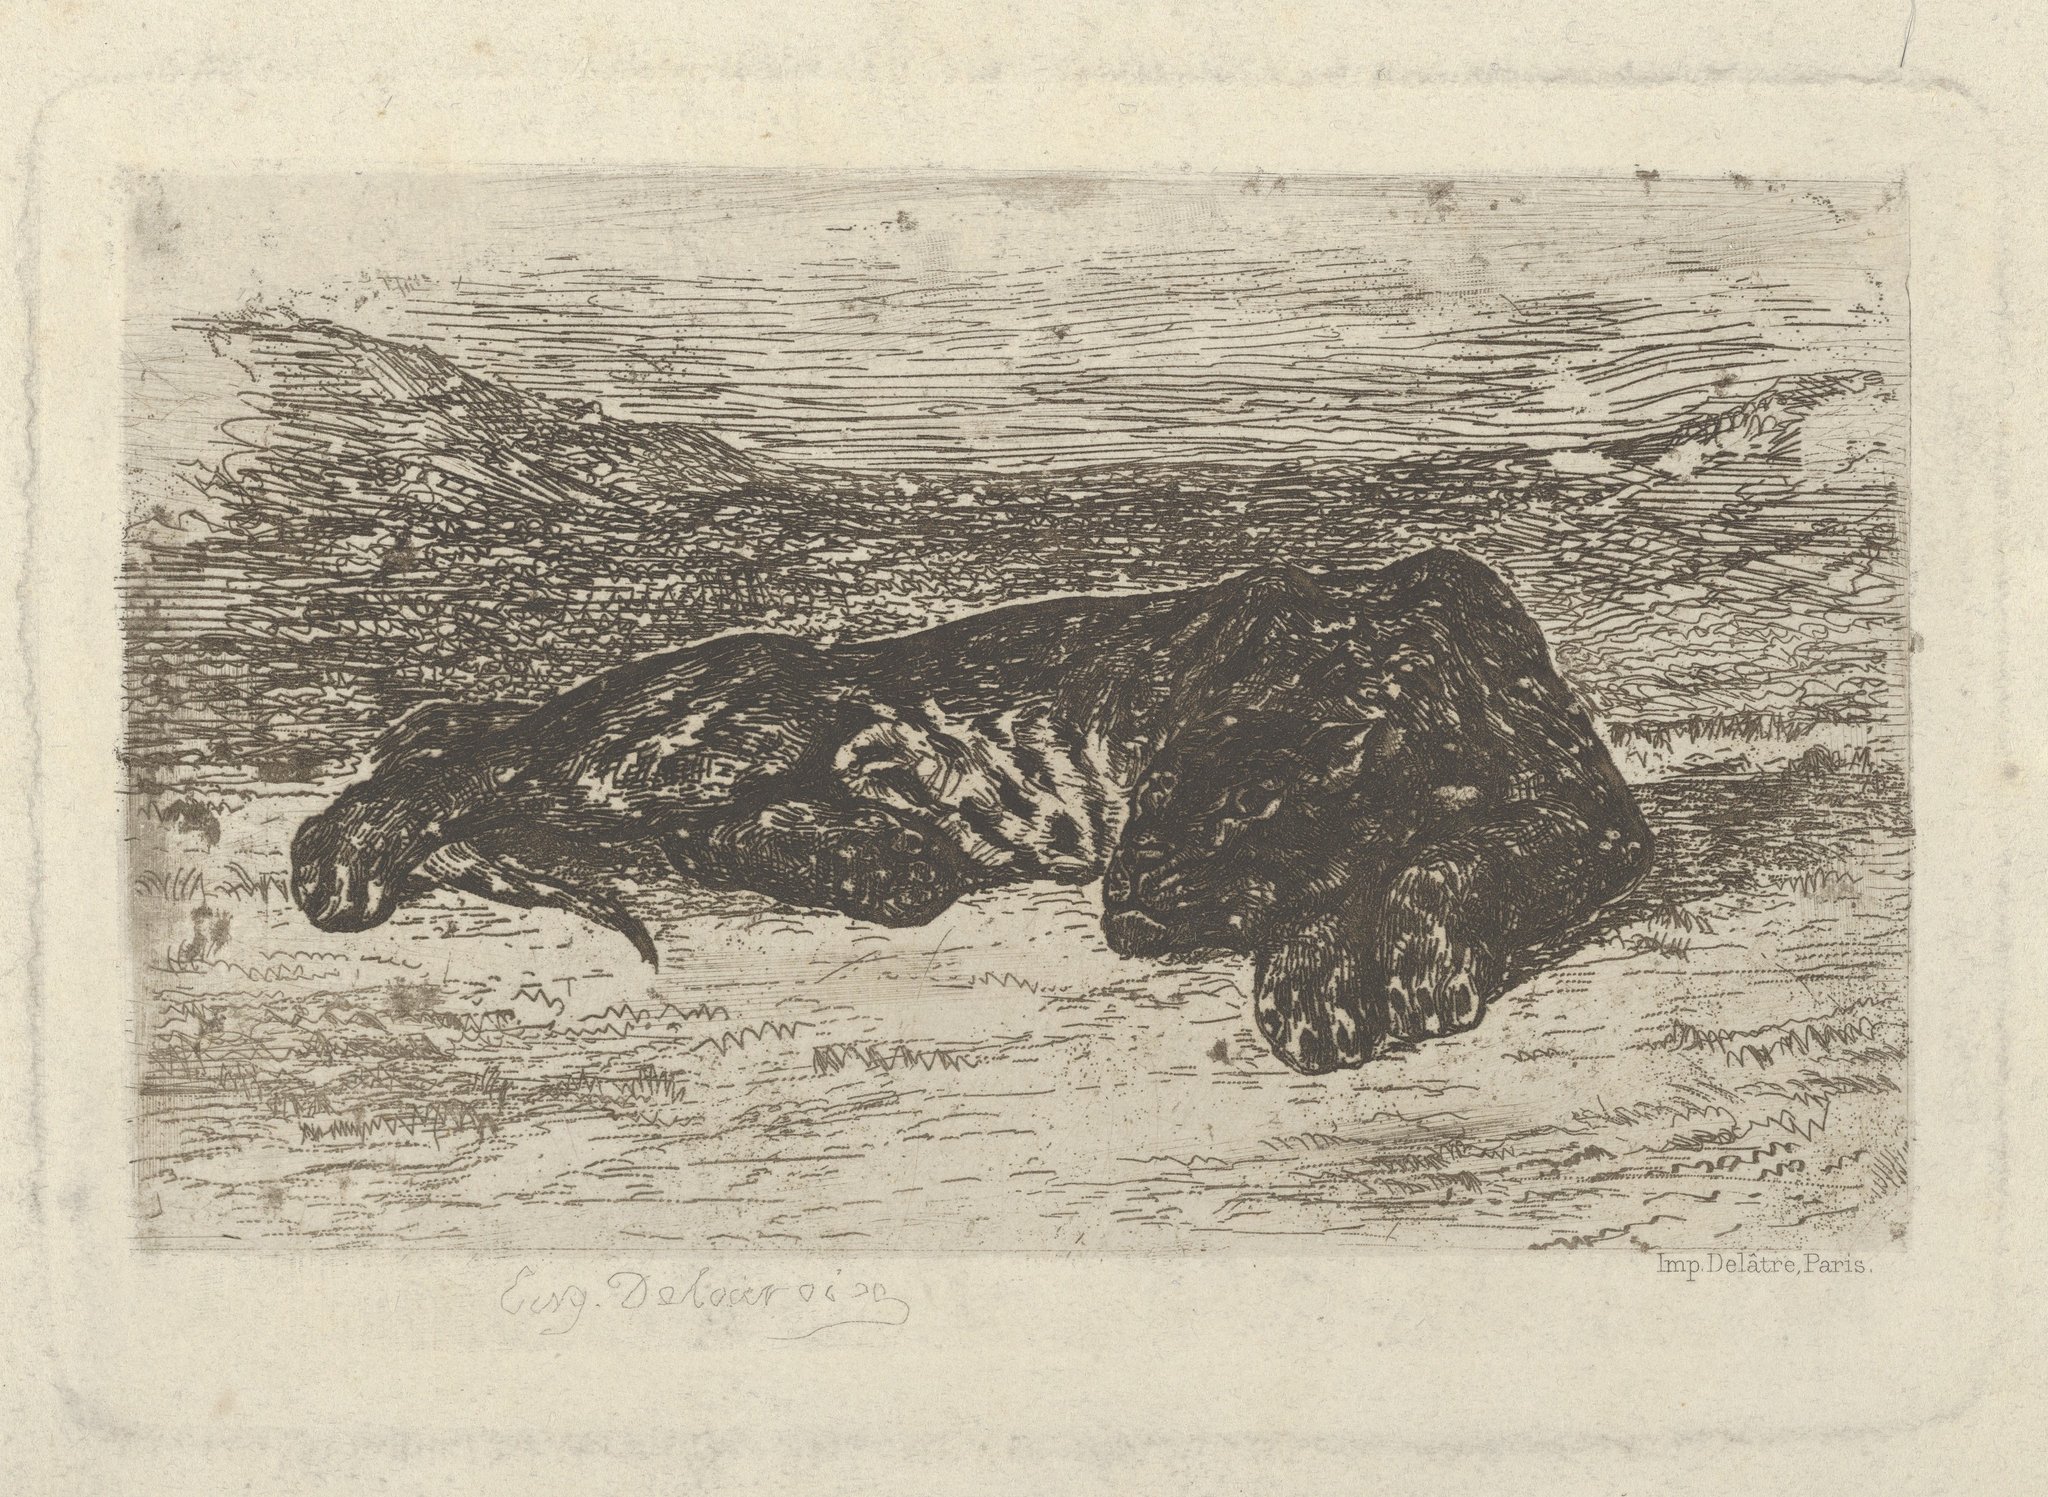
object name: print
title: Tiger Lying in the Desert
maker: eugène delacroix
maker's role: artist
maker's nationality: french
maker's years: 1798-1863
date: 1846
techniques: drypoint, etching, roulette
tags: tigers,deserts